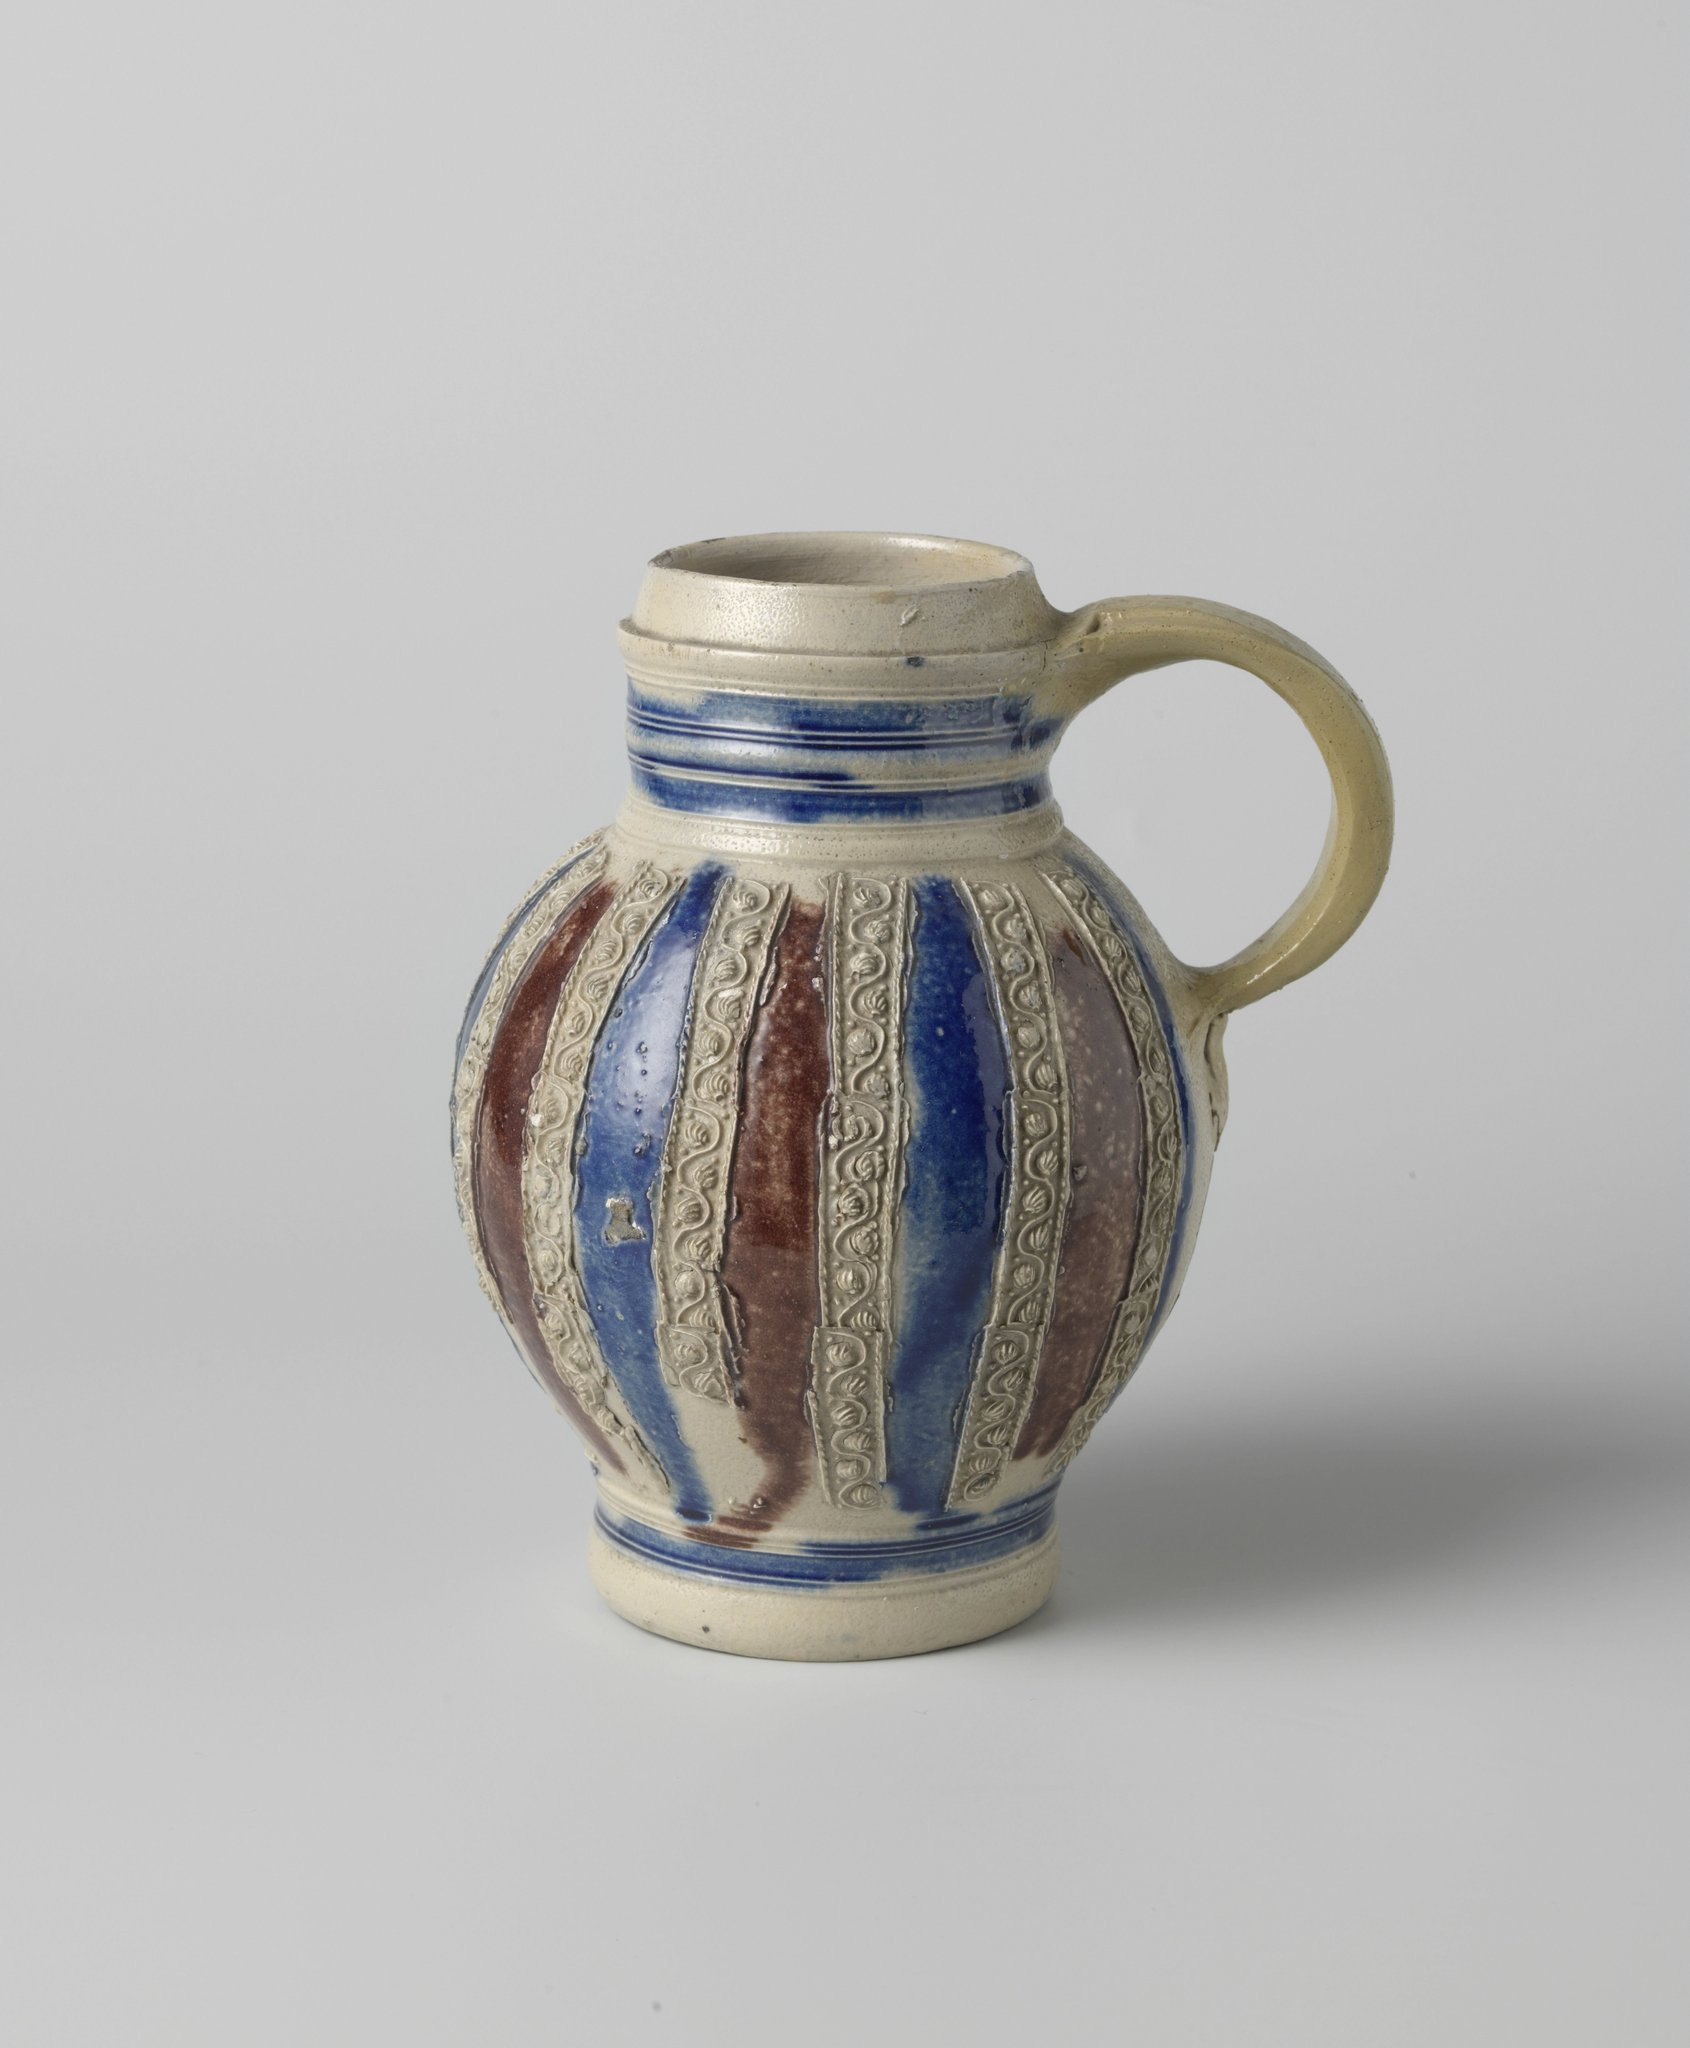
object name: jug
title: Jug with foliate scrolls and colored borders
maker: Anonymous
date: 1600-1699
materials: cobalt, glaze, mineral, stoneware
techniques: firing, forming, relief, turning, vitrification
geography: westerwald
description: Kruik van steengoed op hoge voet met een eivormige buik en wijde, korte nek. Het C-vormige oor is bevestigd aan de nek en de schouder. Op de nek en de voet profielen. Gedeeltelijk bedekt met kobaltblauw en mangaanpaars. Op de buik verticale banden met bladranken gedrukt en opgelegd in reliëf, afgewisseld met een blauwe of paarse band. Op de voet en nek blauwe lijnen. Enkele stukken reliëf ontbreken. Westerwald.